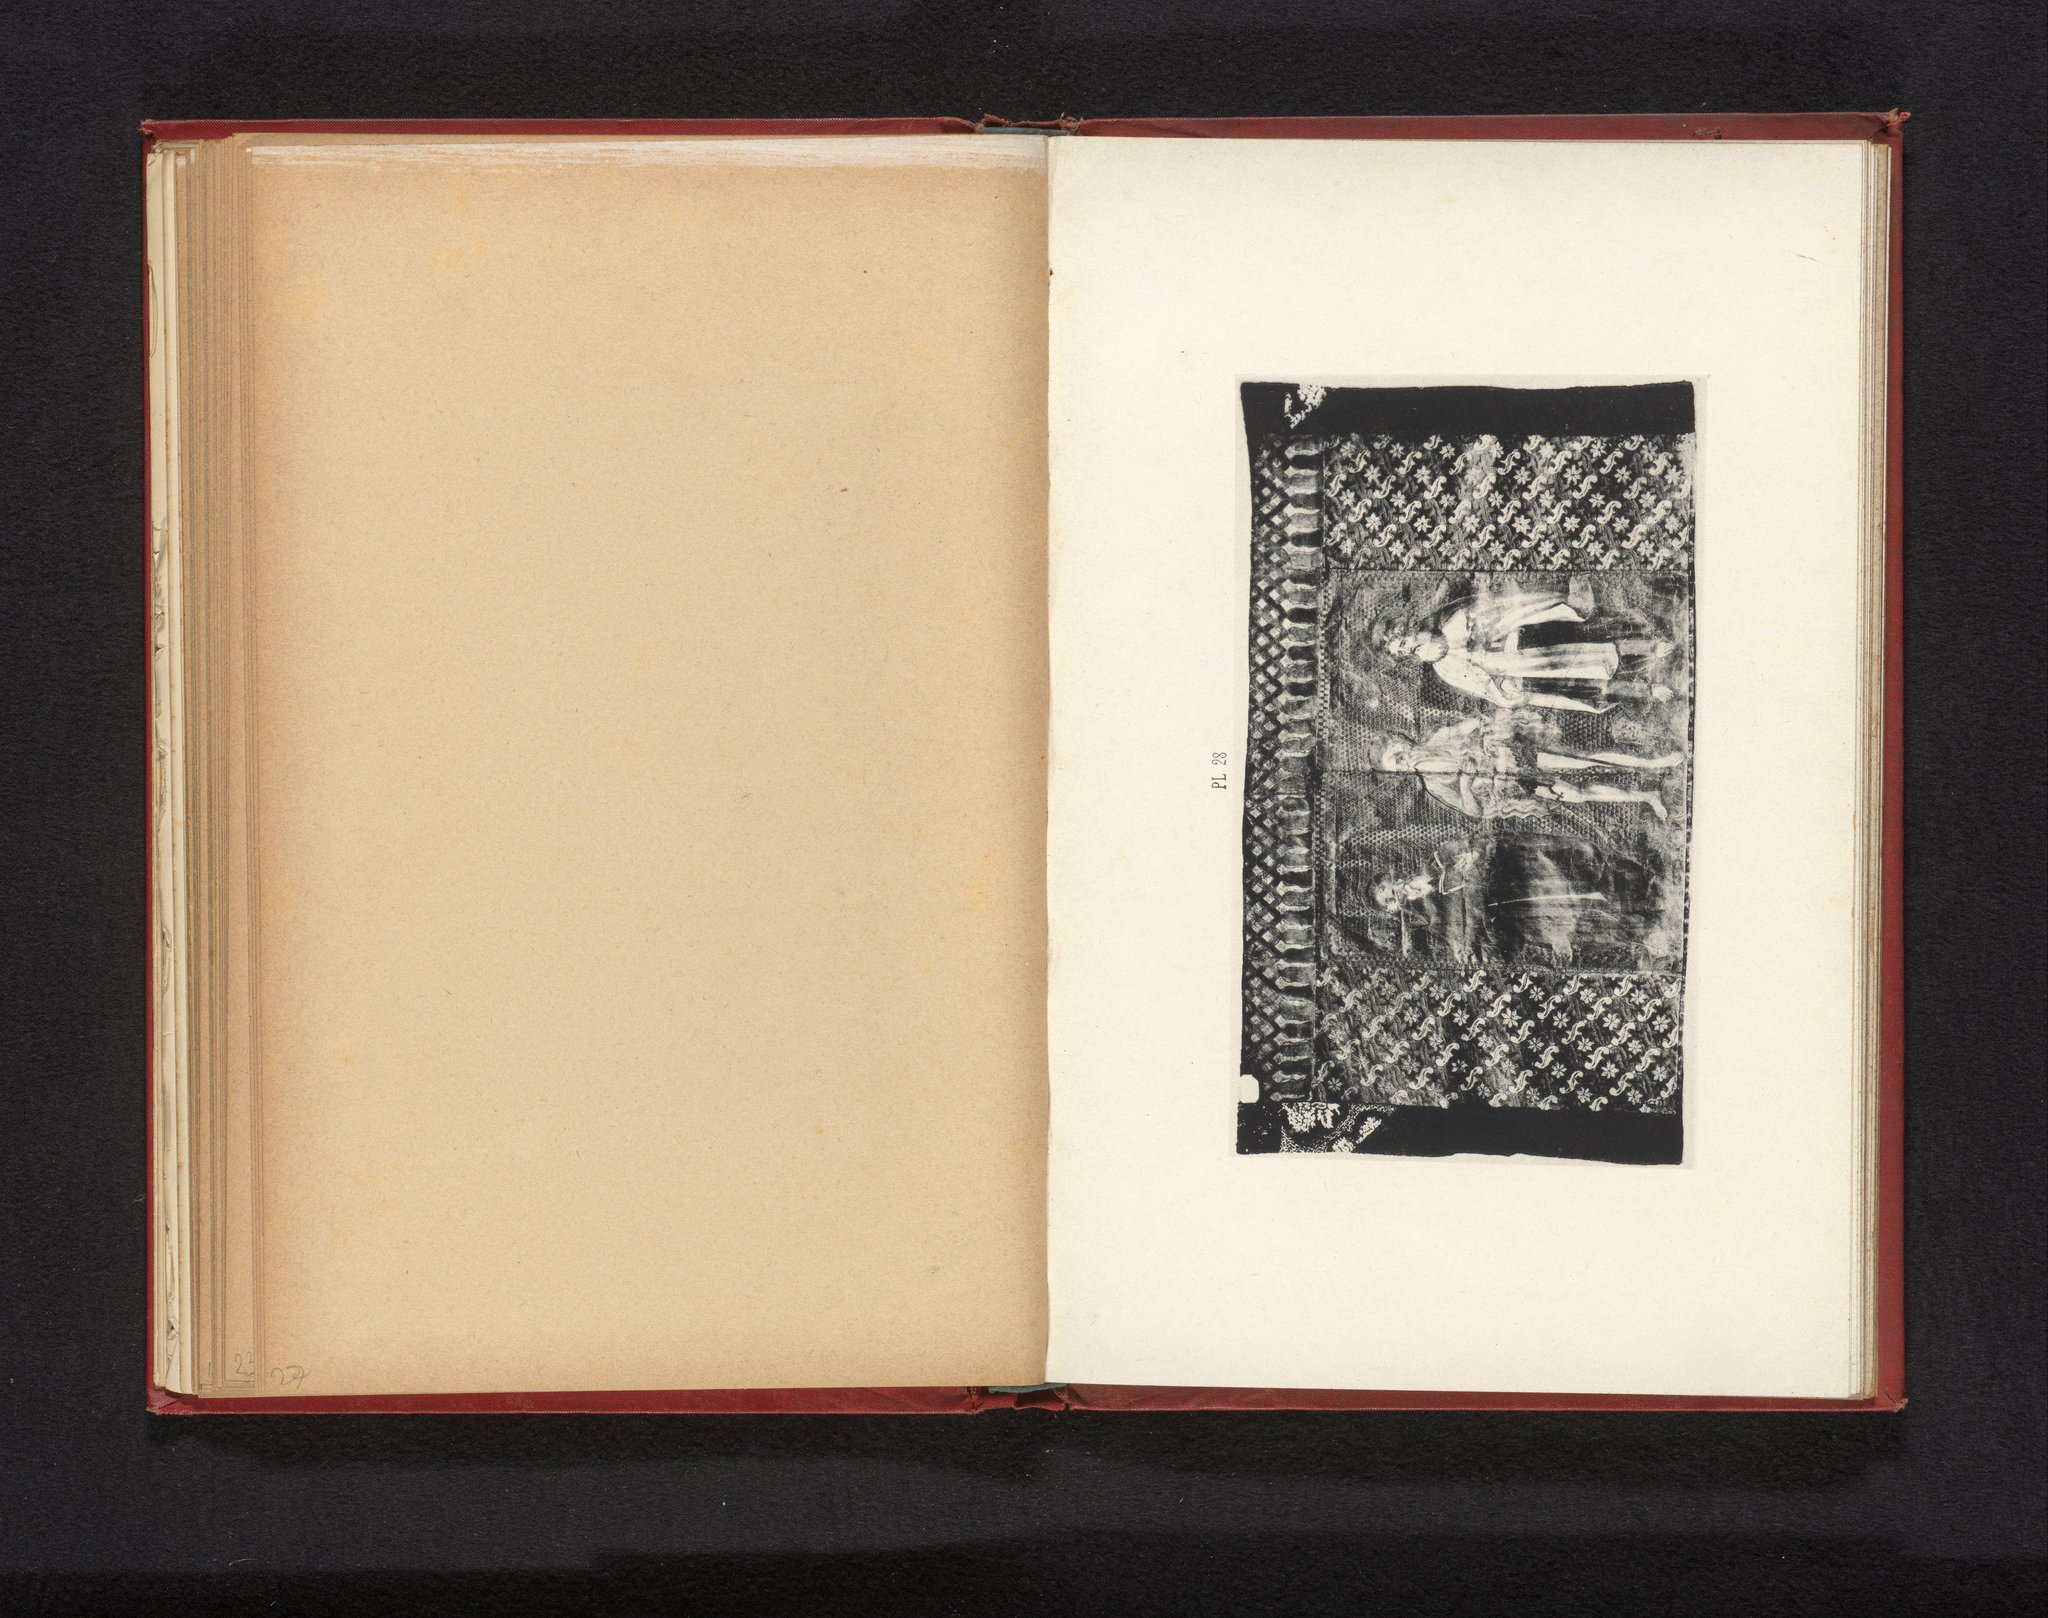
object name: photomechanical print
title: Tapijt met een afbeelding van (vermoedelijk) drie kerkvaders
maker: Anonymous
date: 1880-1881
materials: paper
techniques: photograph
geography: barcelona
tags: carpet, rug, doctors (fathers) of the church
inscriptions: number: ‘Pl 28’